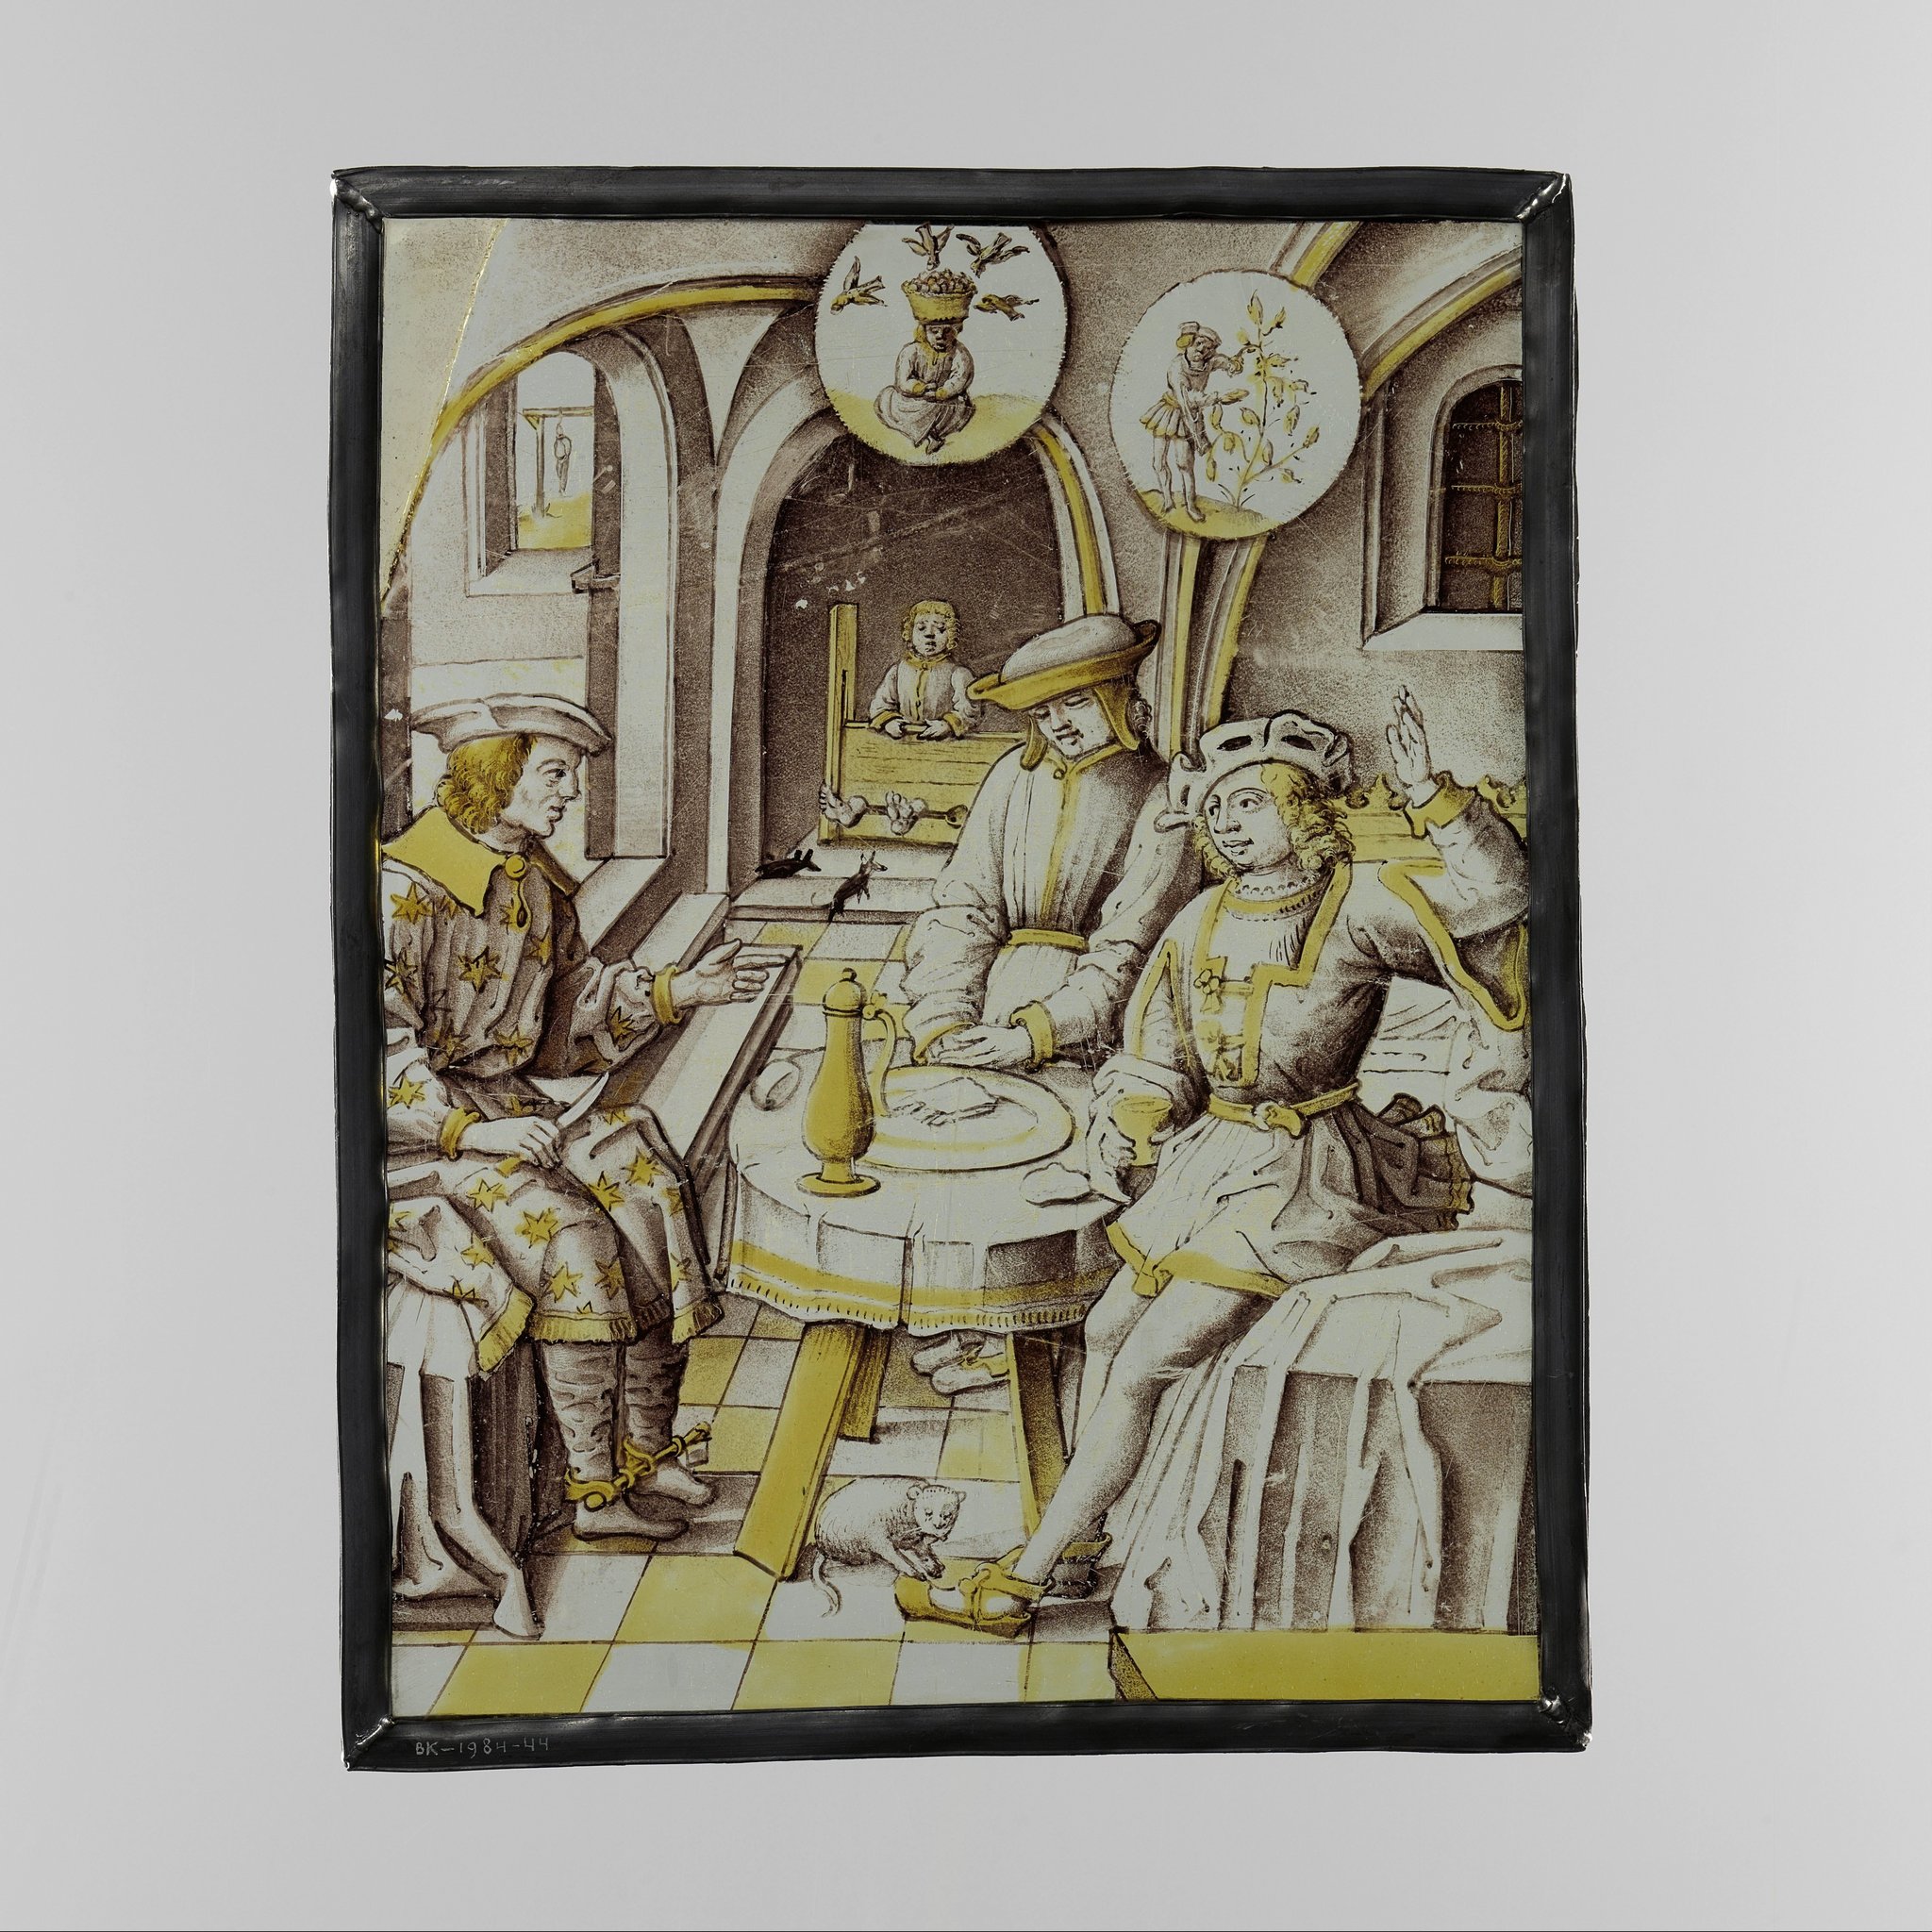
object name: light window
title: Ruit met Jozef die de dromen van de schenker en de bakker uitlegt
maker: Anonymous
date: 1515-1525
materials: glass, lead, pigment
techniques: leading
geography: northern netherlands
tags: joseph interpreting the dreams of the butler and the baker (the two dreams combined)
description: Joseph Interpreting the Dreams of the Butler and the Baker in Prison. Stained glass. Netherlands, c. 1525.